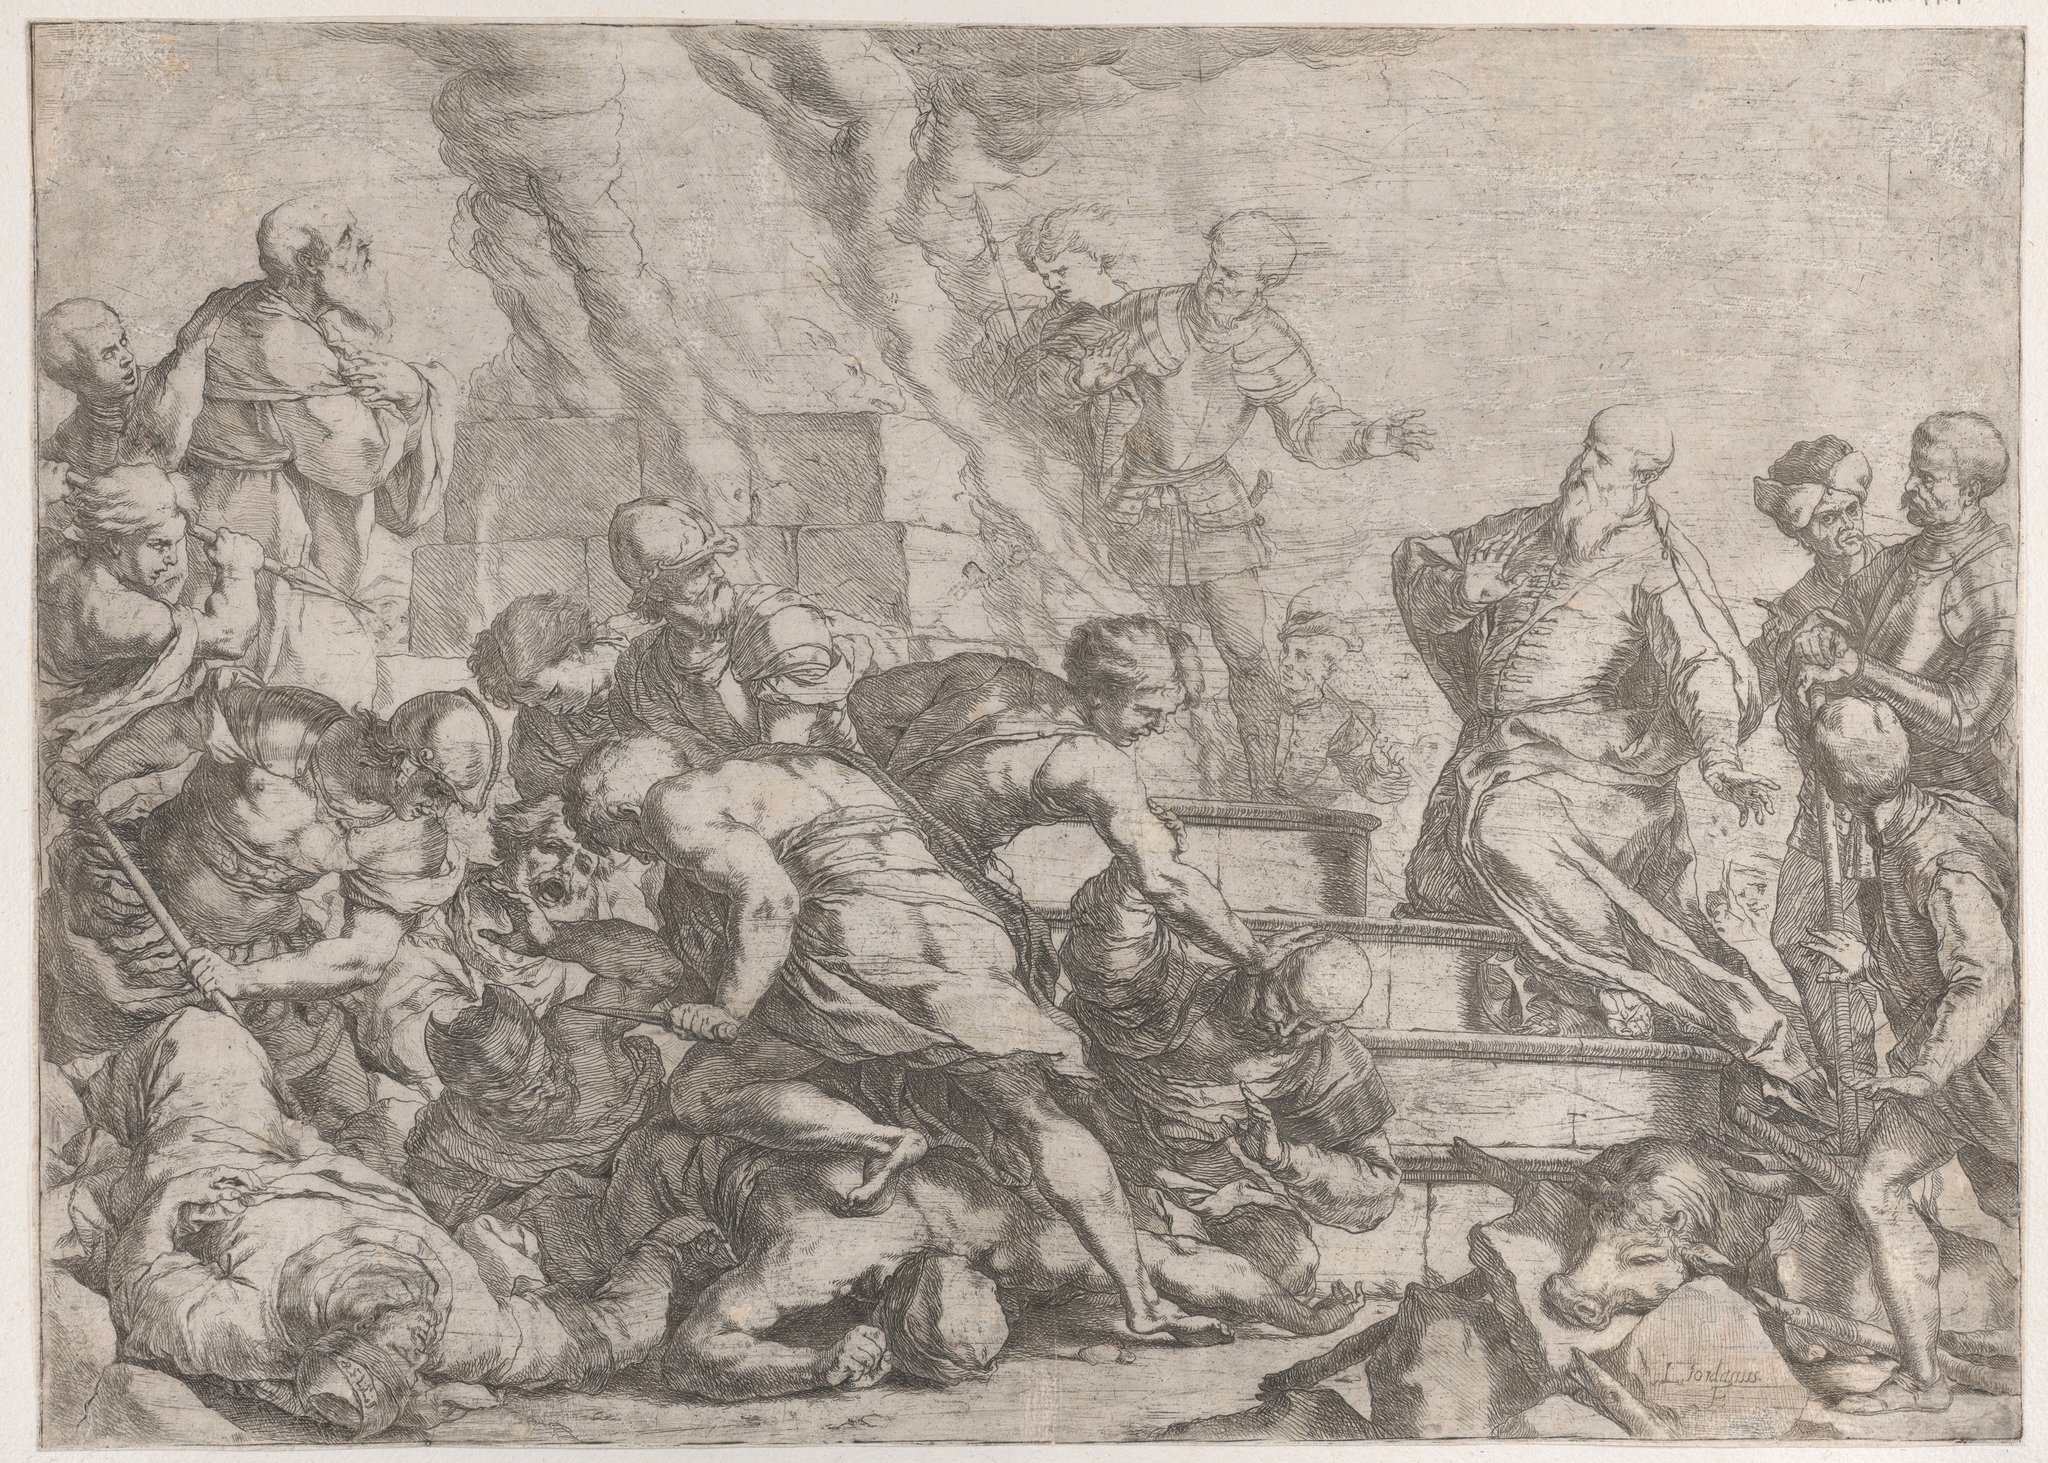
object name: print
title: The sacrifice of Elijah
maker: luca giordano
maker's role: artist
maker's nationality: italian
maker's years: 1634-1705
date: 1653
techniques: etching